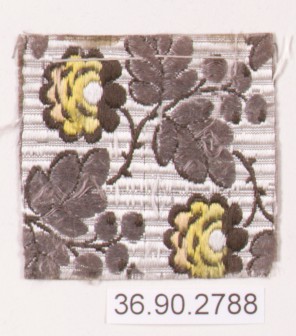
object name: piece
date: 1801-1900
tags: flowers,leaves